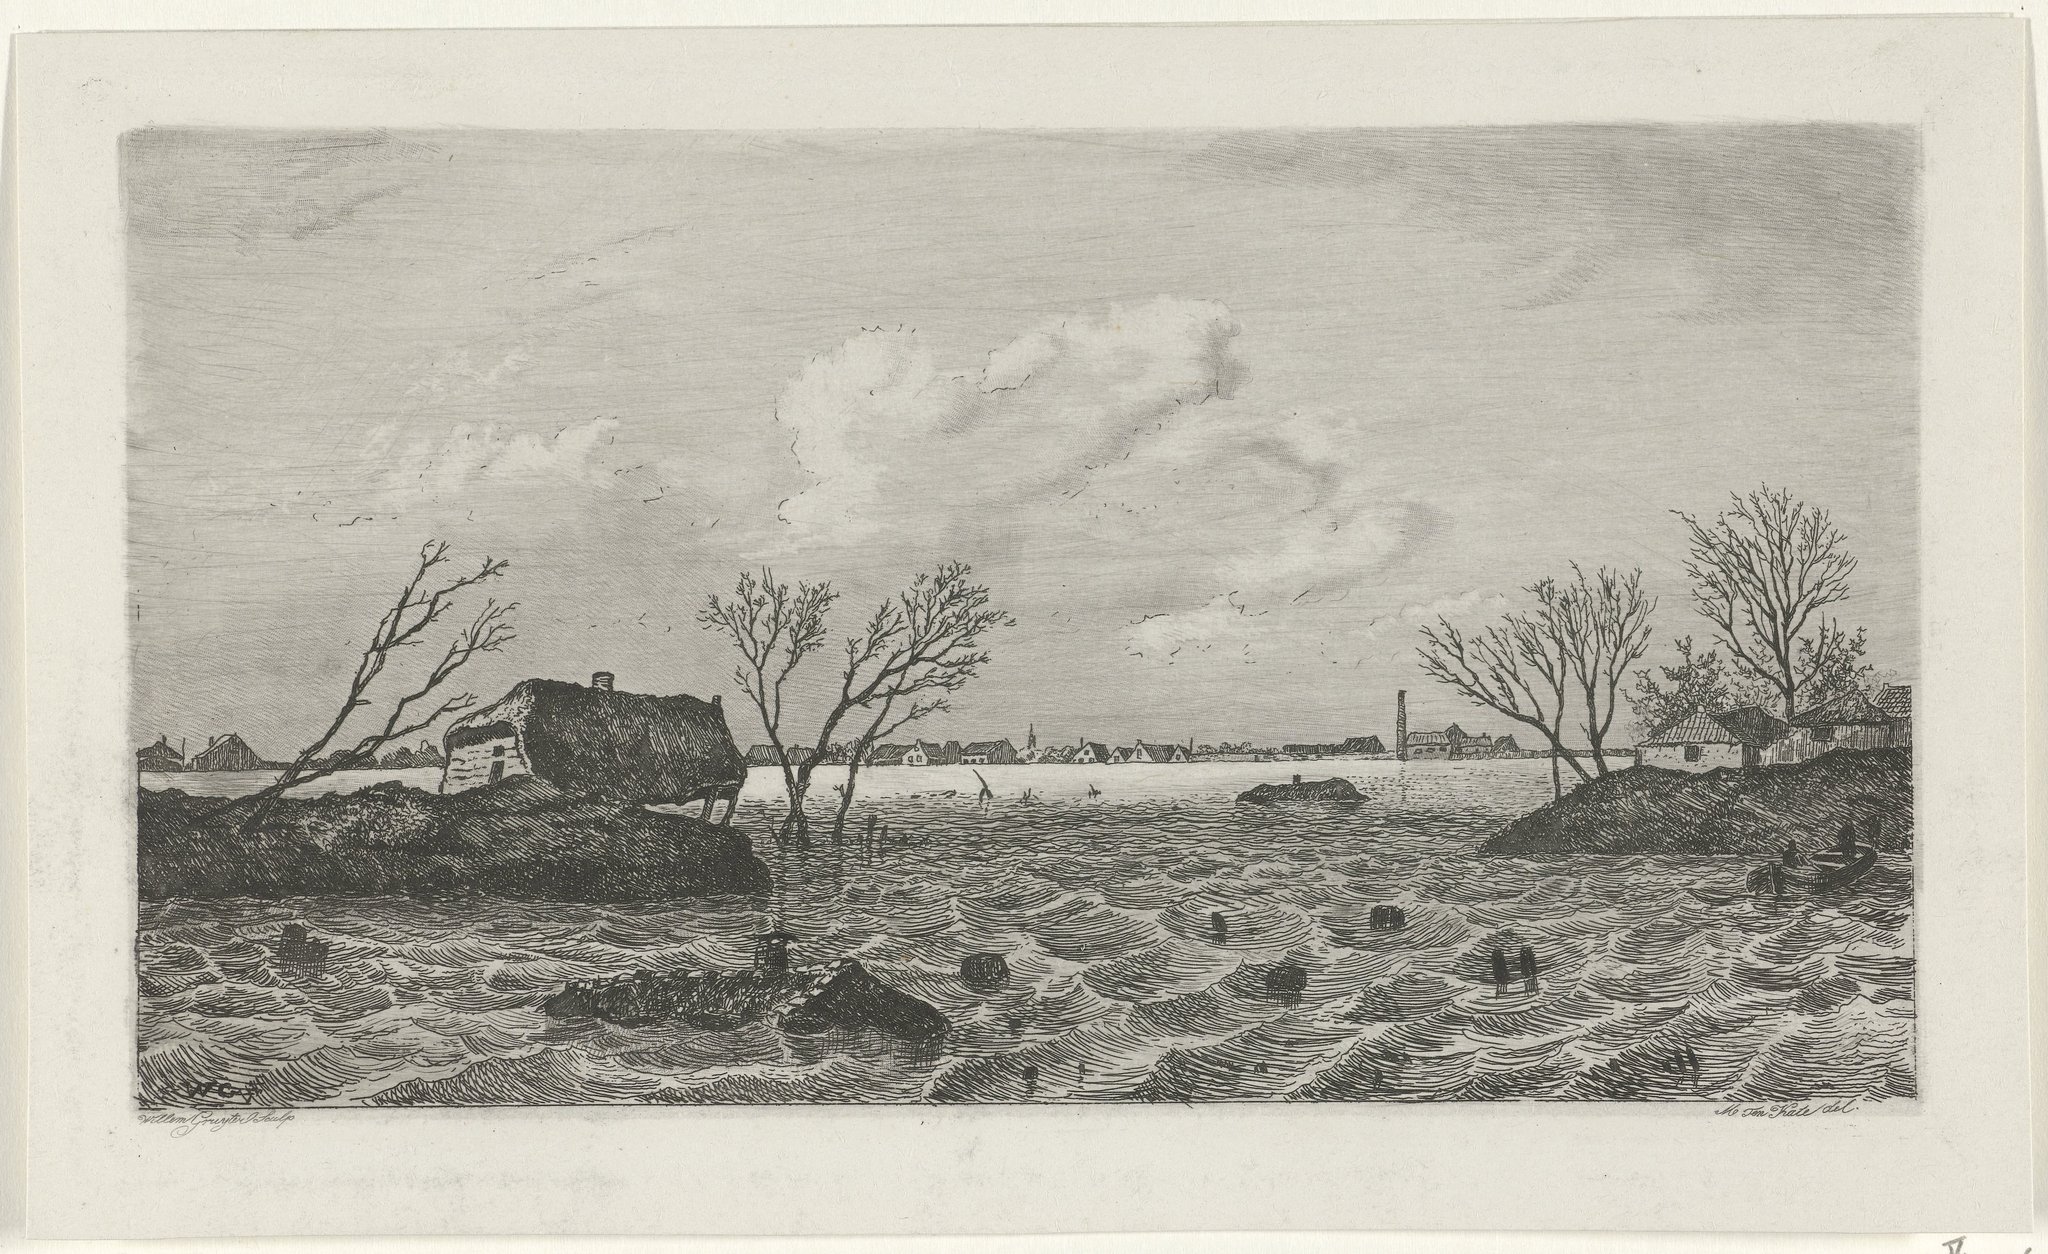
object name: print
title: Dijkdoorbraak bij Dreumel, 1855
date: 1832-1880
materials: paper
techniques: aquatint, etching, roulette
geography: amsterdam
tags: dike-break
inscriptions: collector's mark: Lugt 2165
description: Landschap met dijkdoorbraak bij Dreumel tijdens de watersnoodramp in 1855.